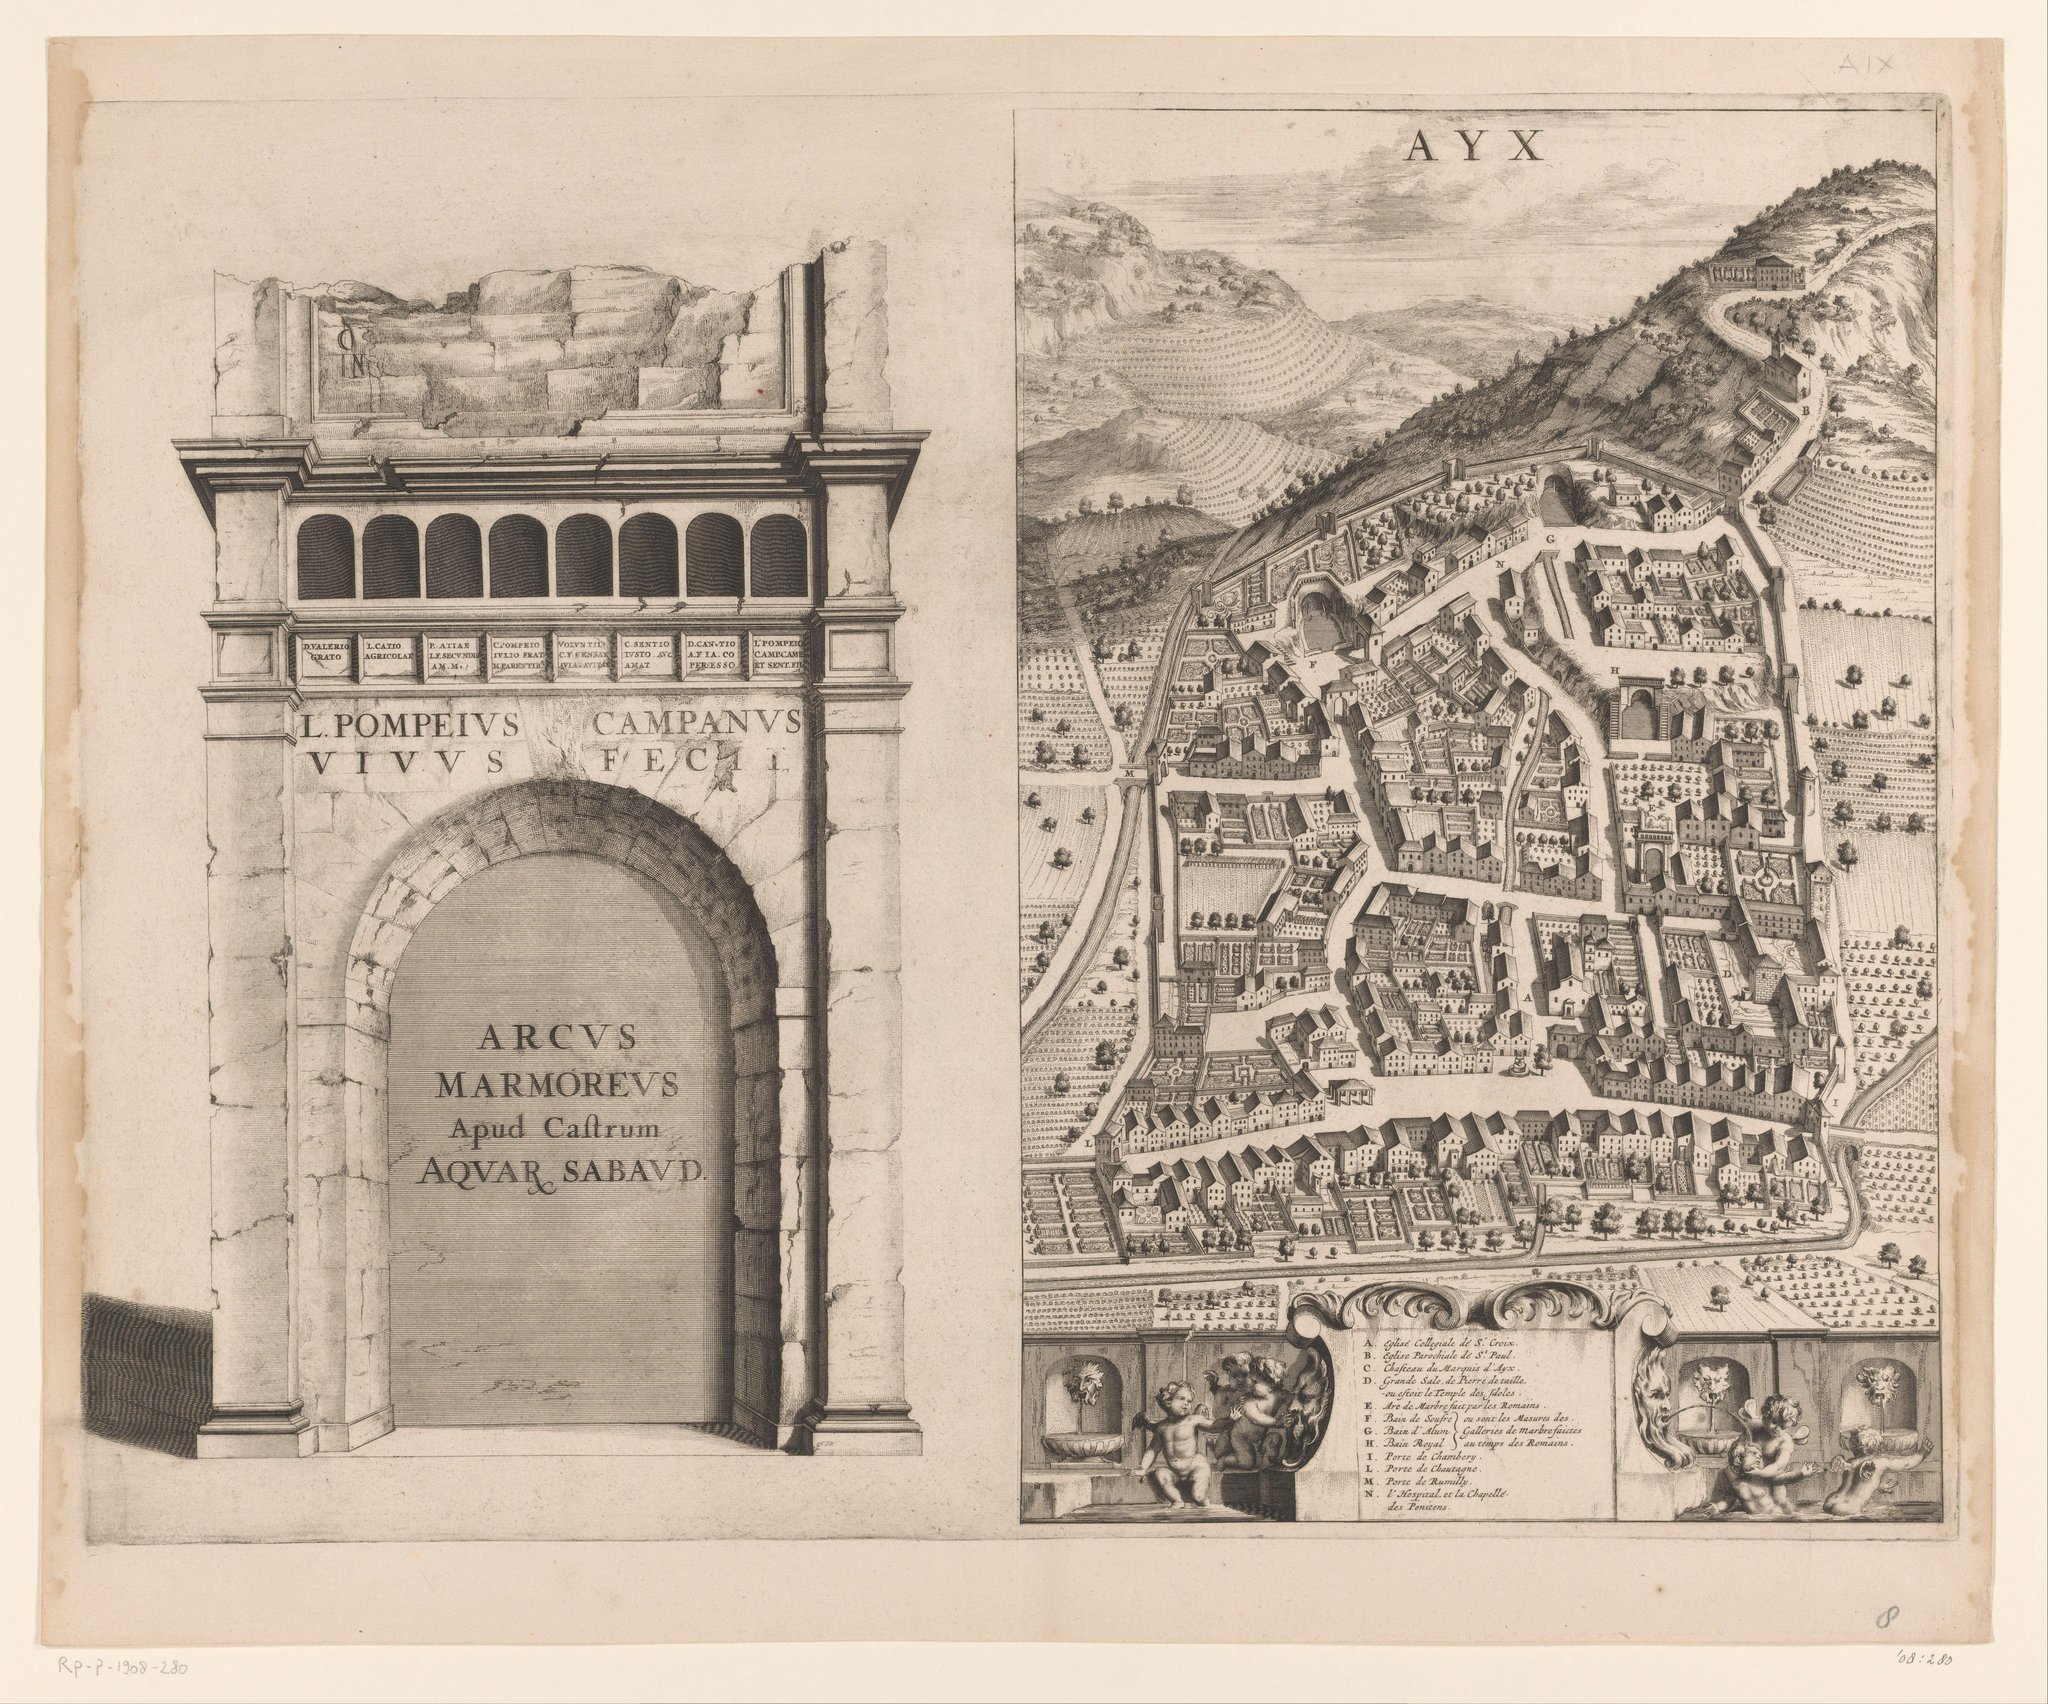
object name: area plan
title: Plattegrond van Aix-les-Bains en een gezicht op de Arc de Campanus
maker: Anonymous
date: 1682-1697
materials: paper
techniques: engraving, etching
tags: triumphal arch, maps of cities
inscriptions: collector's mark: Lugt 2228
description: Rechts een plattegrond van Aix-les-Bains in vogelvluchtperspectief. Links een gezicht op de Arc de Campanus in dezelfde stad.